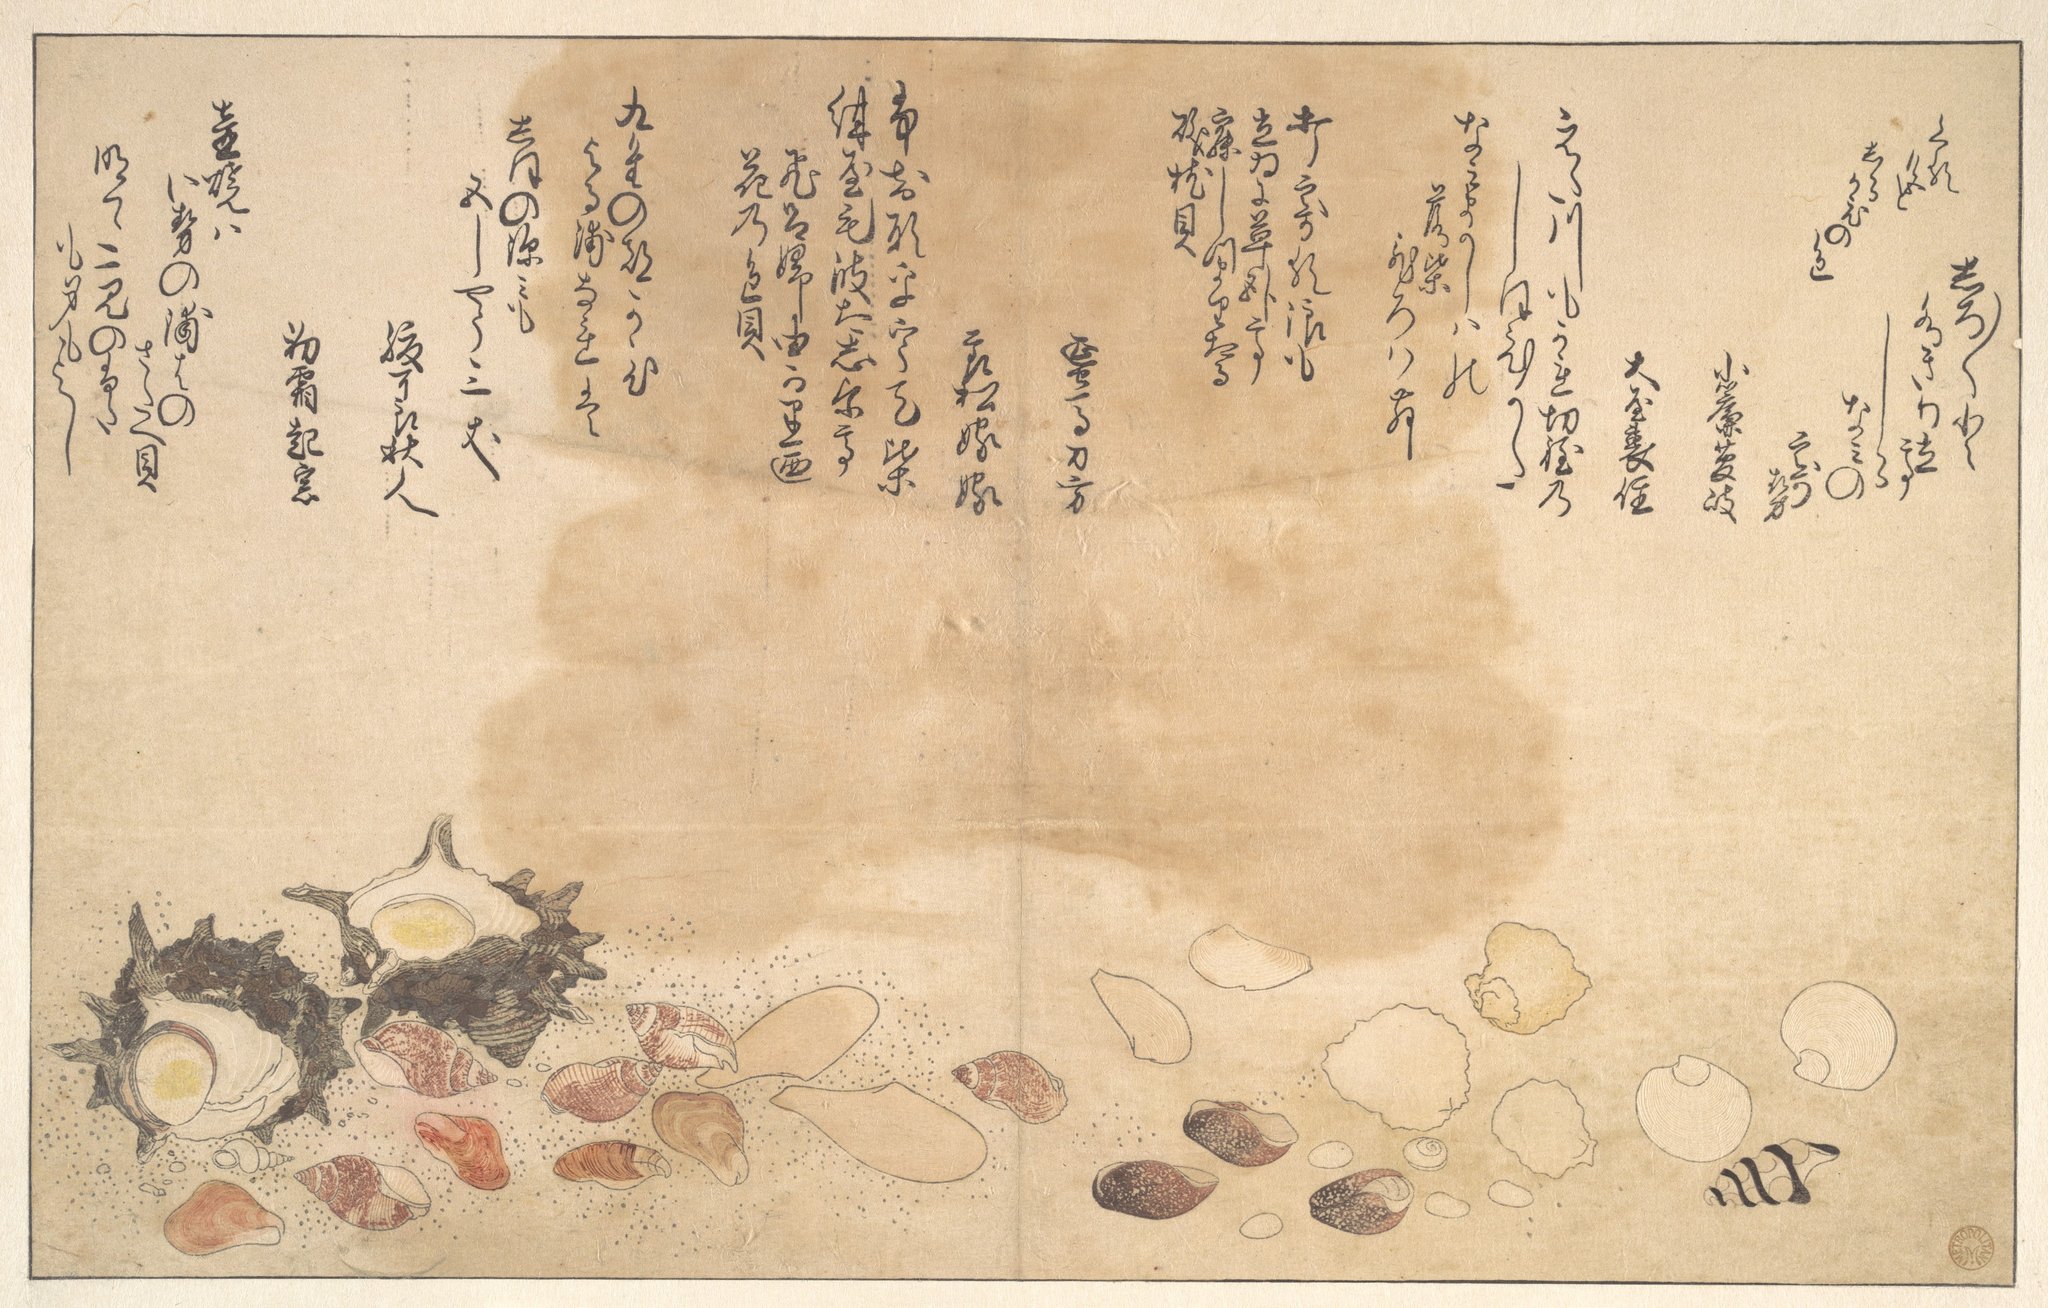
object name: print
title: Shells under Water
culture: japanese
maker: kitagawa utamaro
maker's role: artist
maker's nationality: japanese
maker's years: 1754-1806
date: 1790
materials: ink, paper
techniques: woodblock print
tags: shells